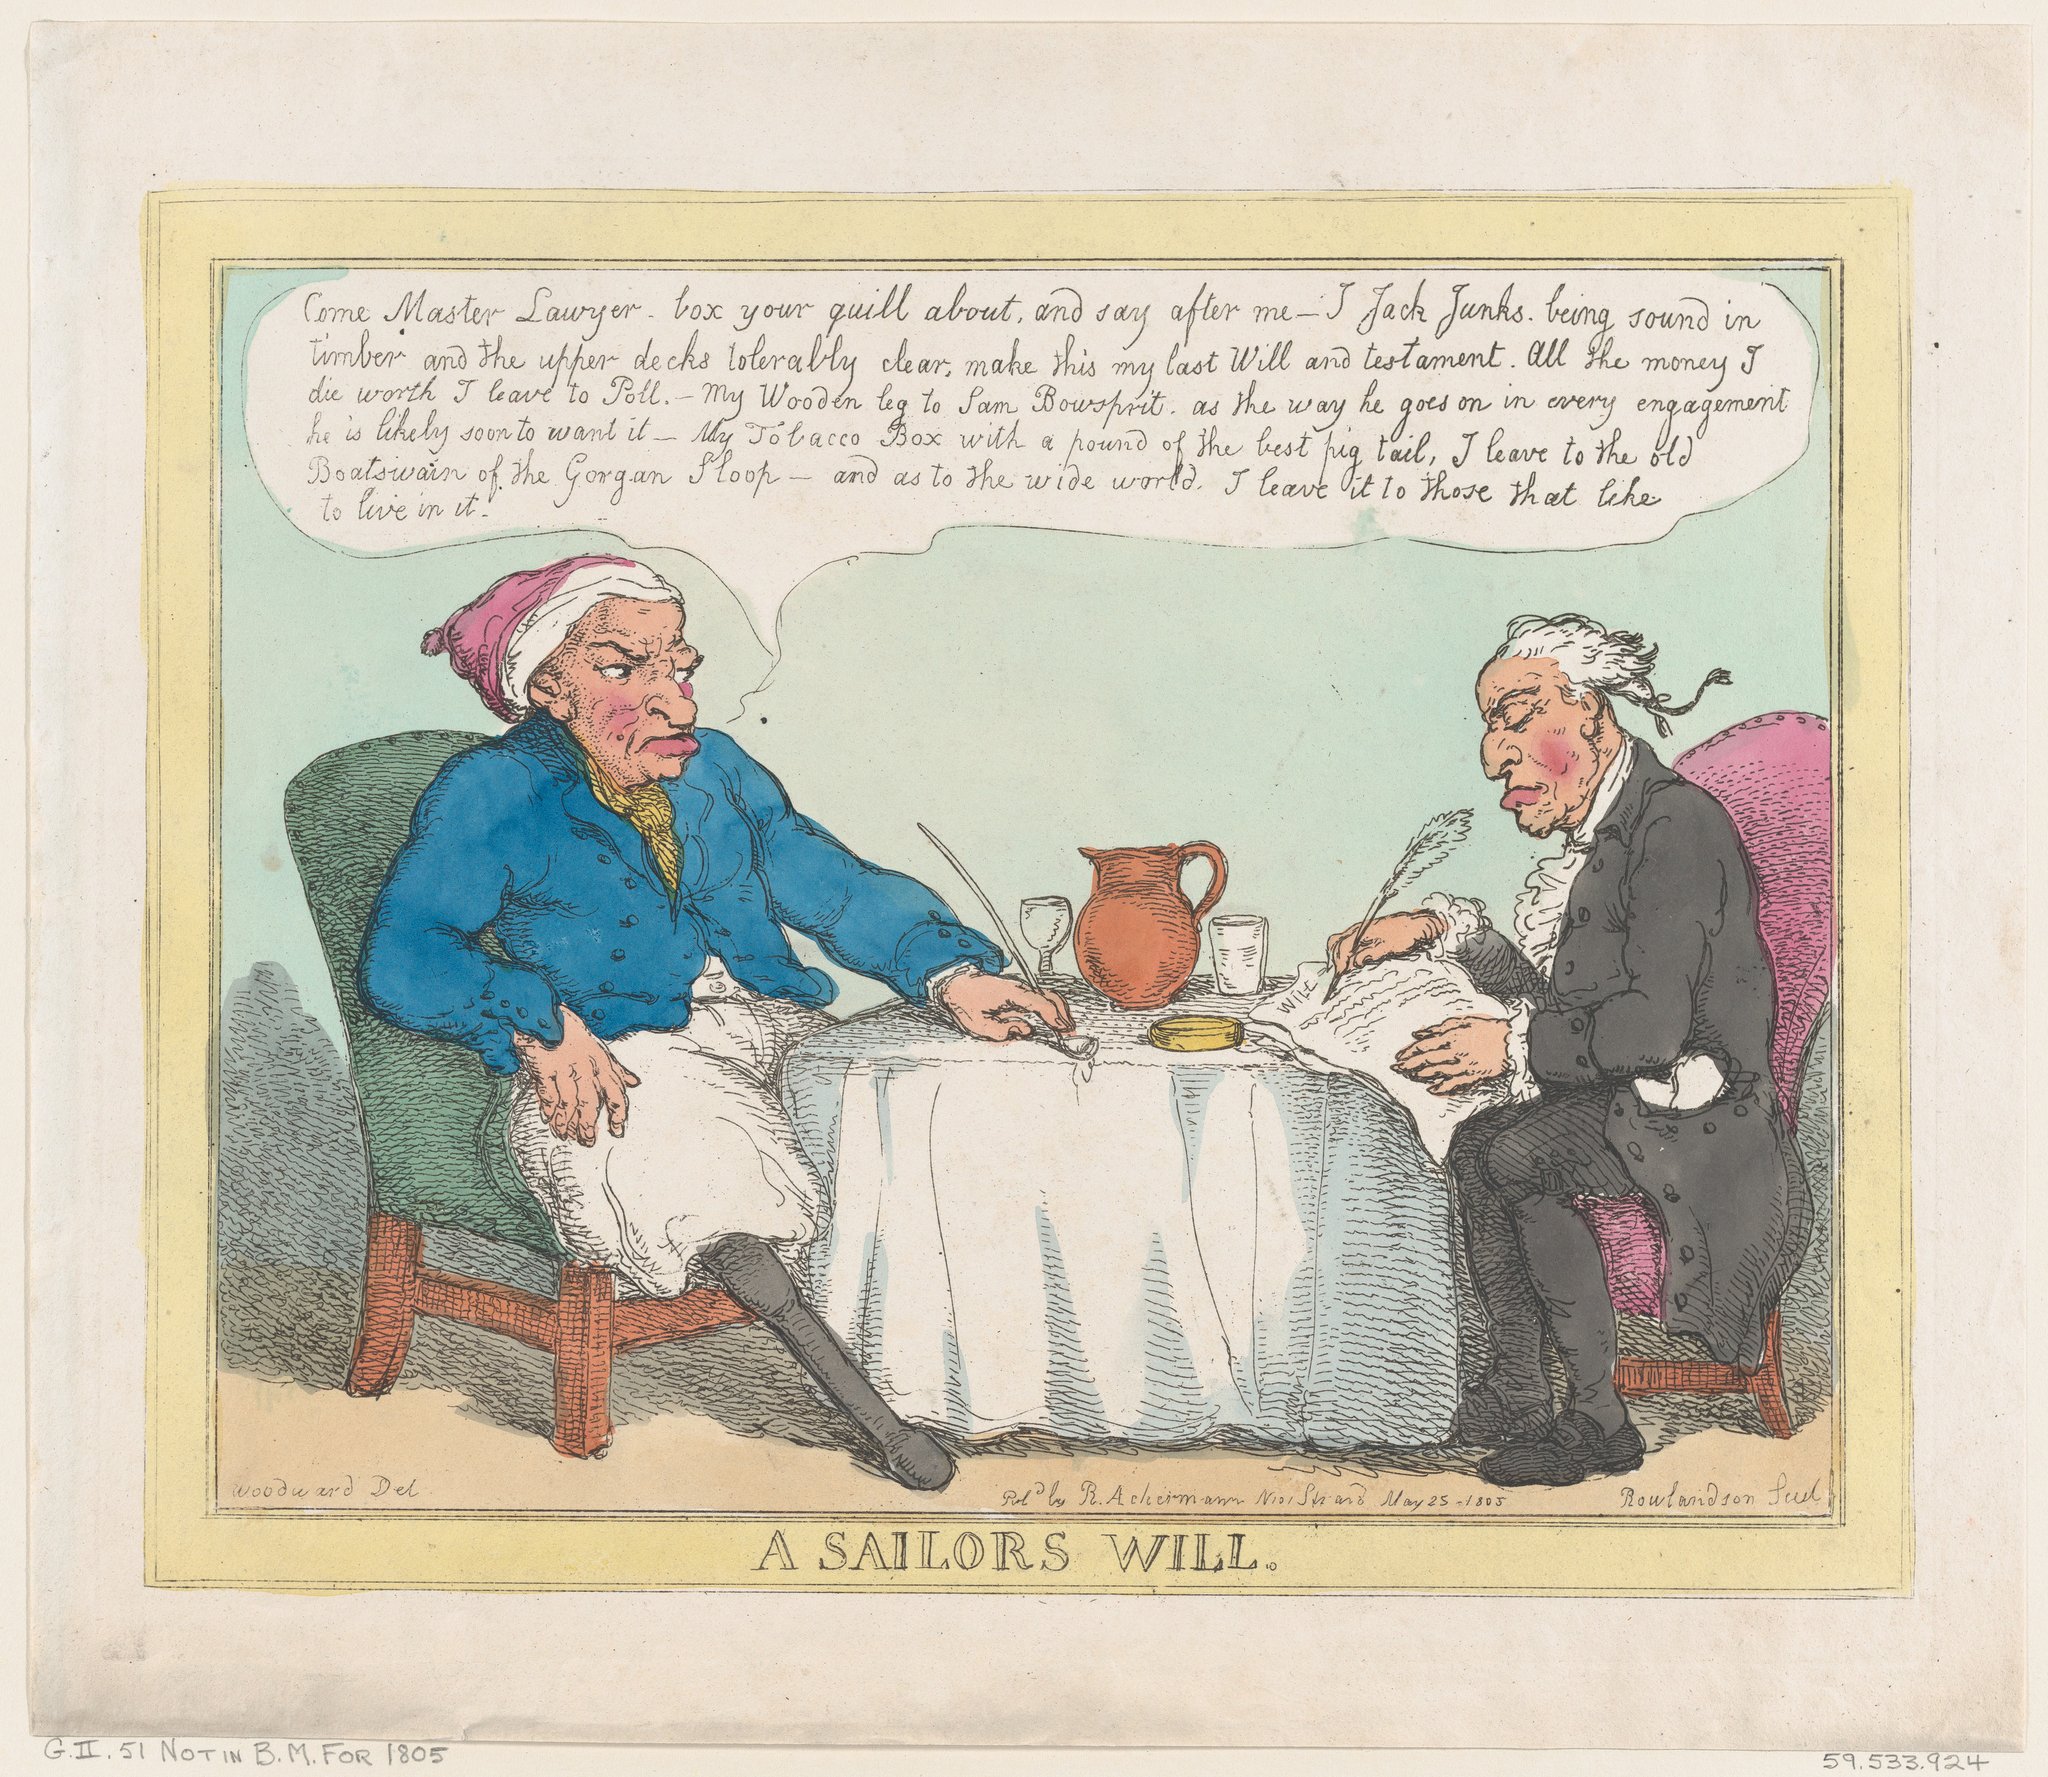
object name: print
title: A Sailor's Will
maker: thomas rowlandson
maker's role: artist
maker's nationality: british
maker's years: 1757-1827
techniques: etching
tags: satire,men,writing,sailors